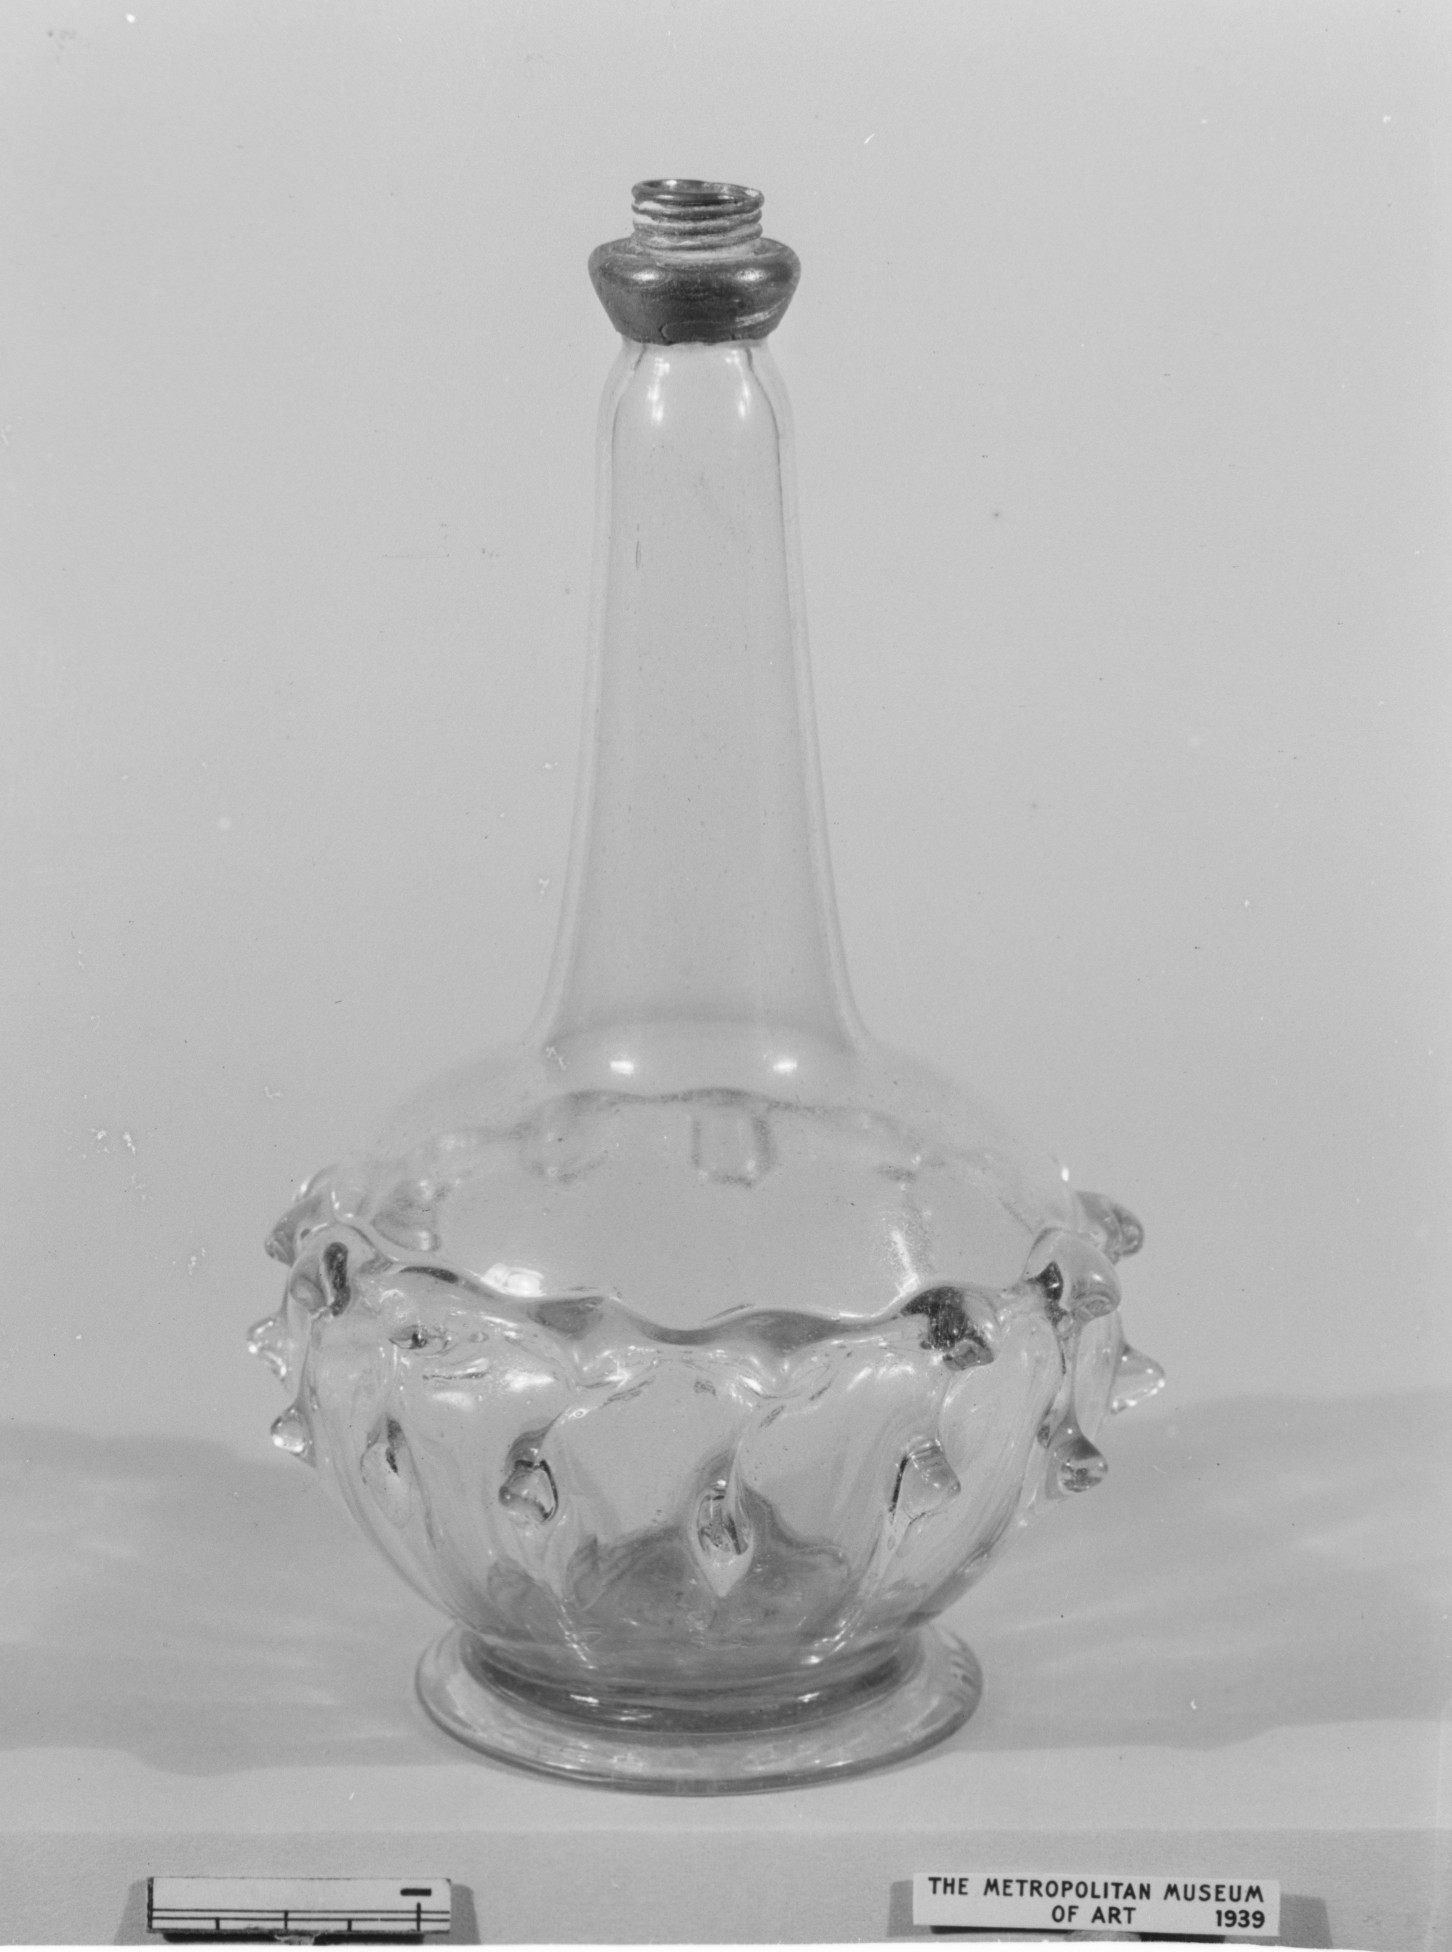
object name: bottle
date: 1667-1700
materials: glass